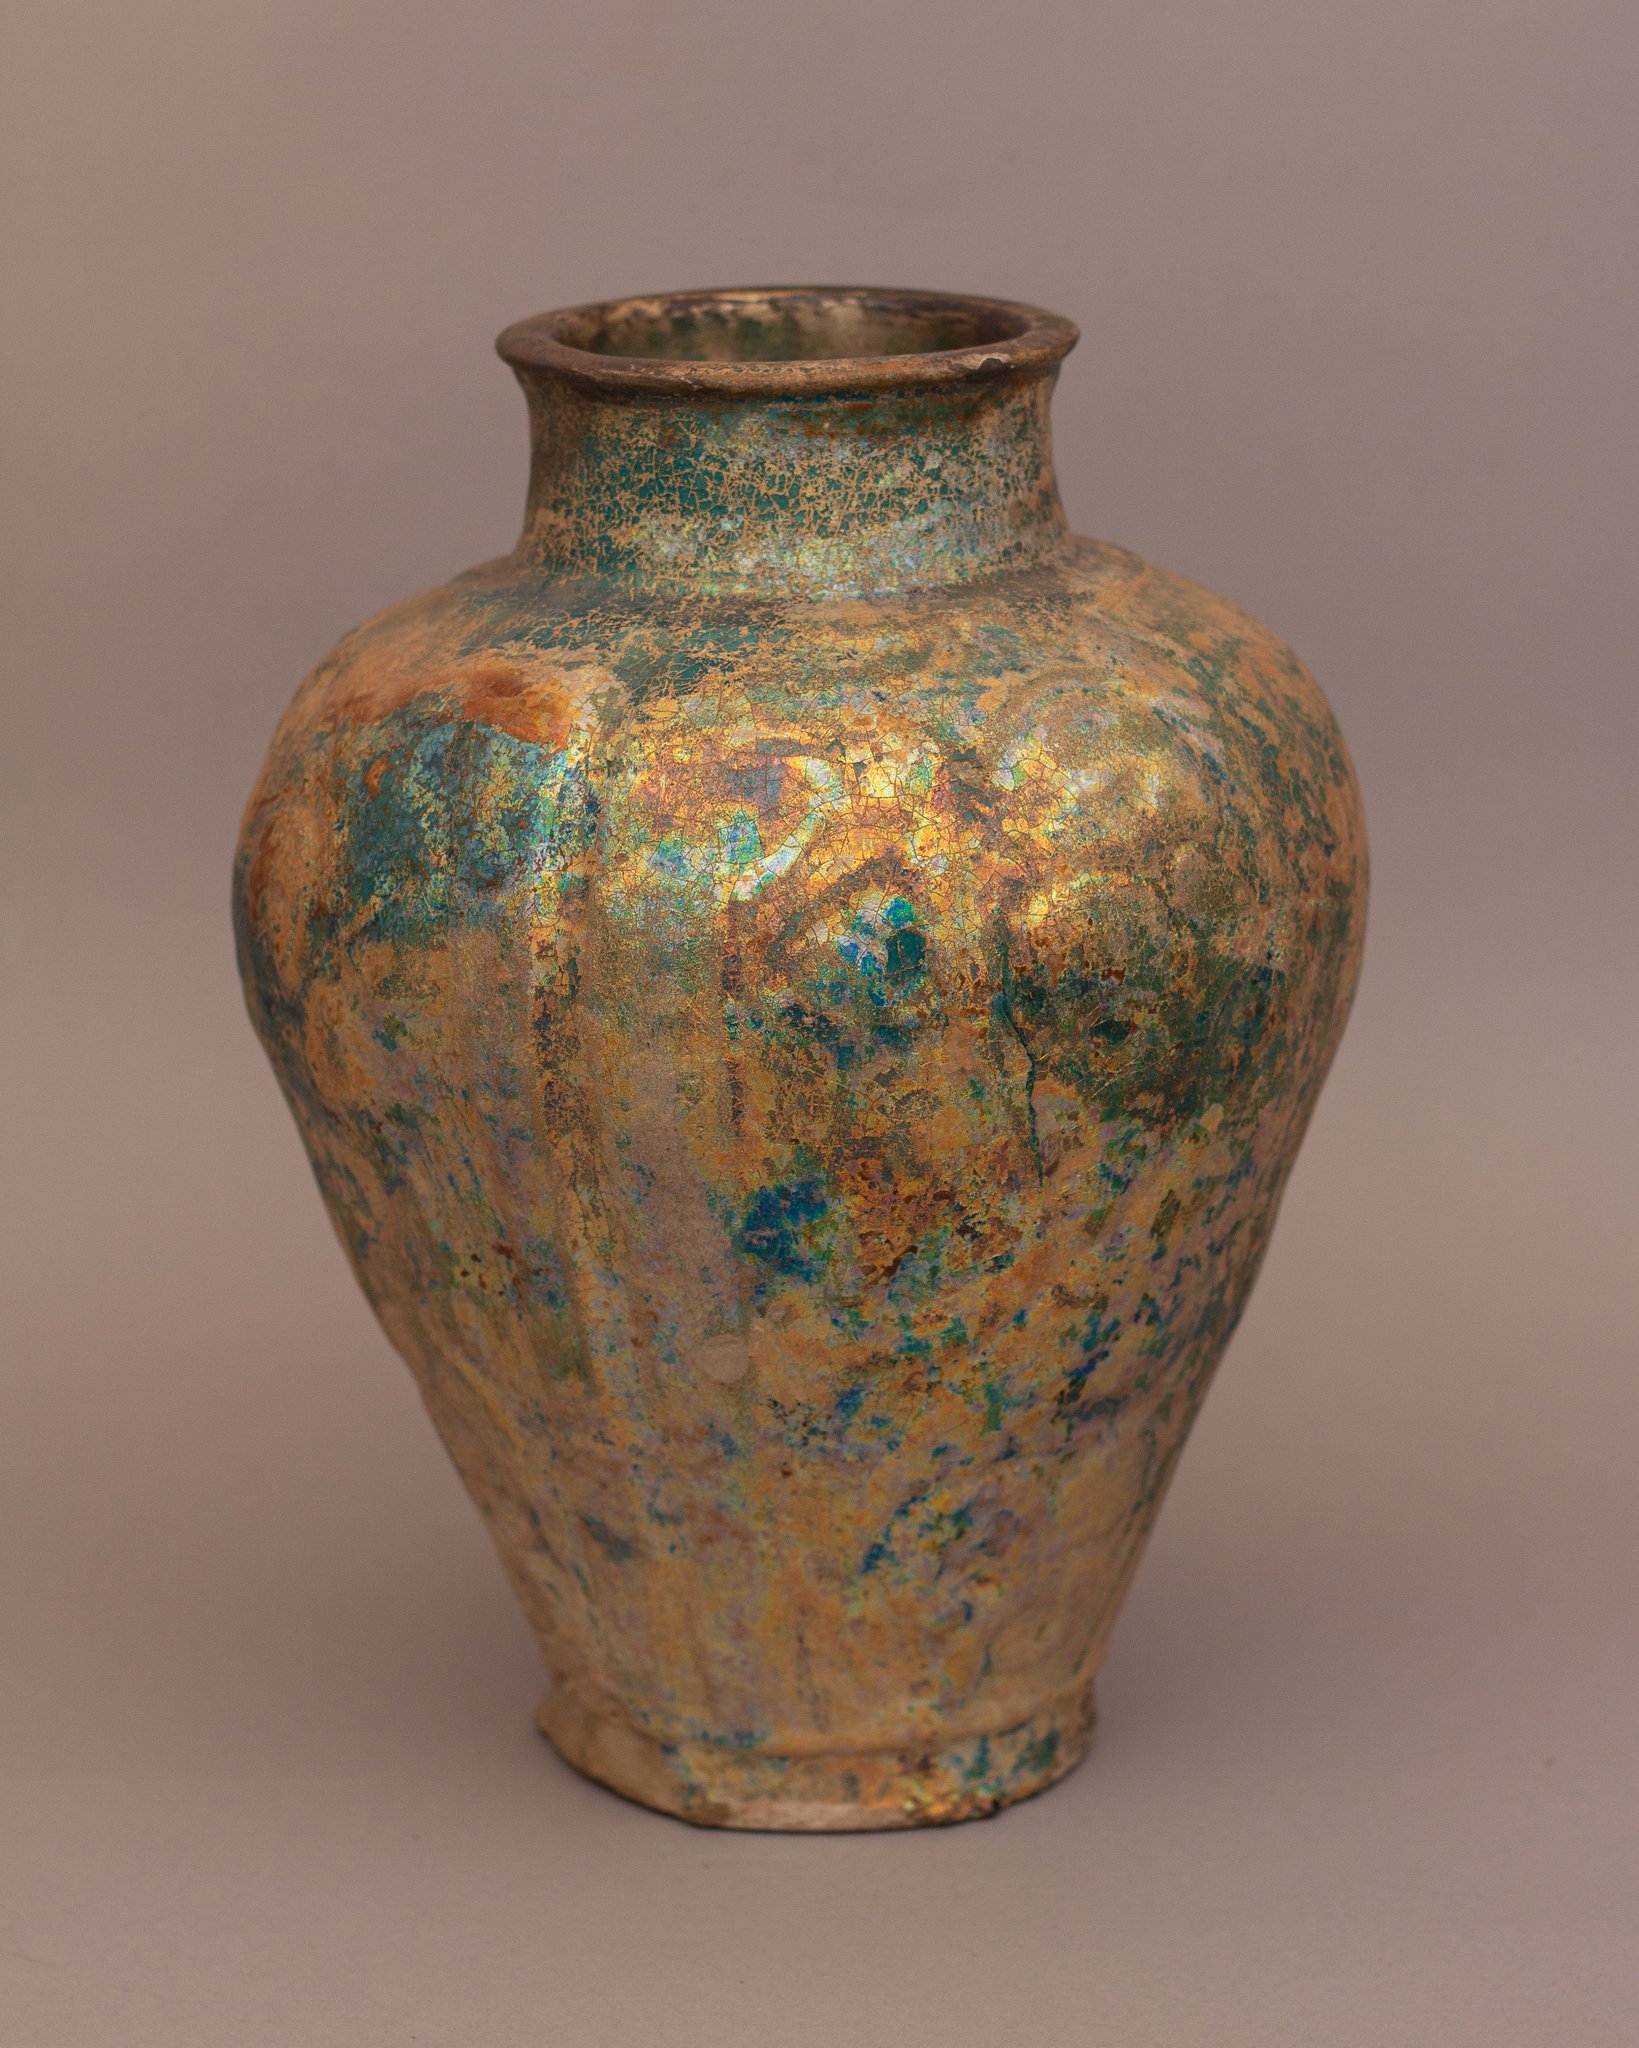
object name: jar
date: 1101-1200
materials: earthenware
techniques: glazing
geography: syria